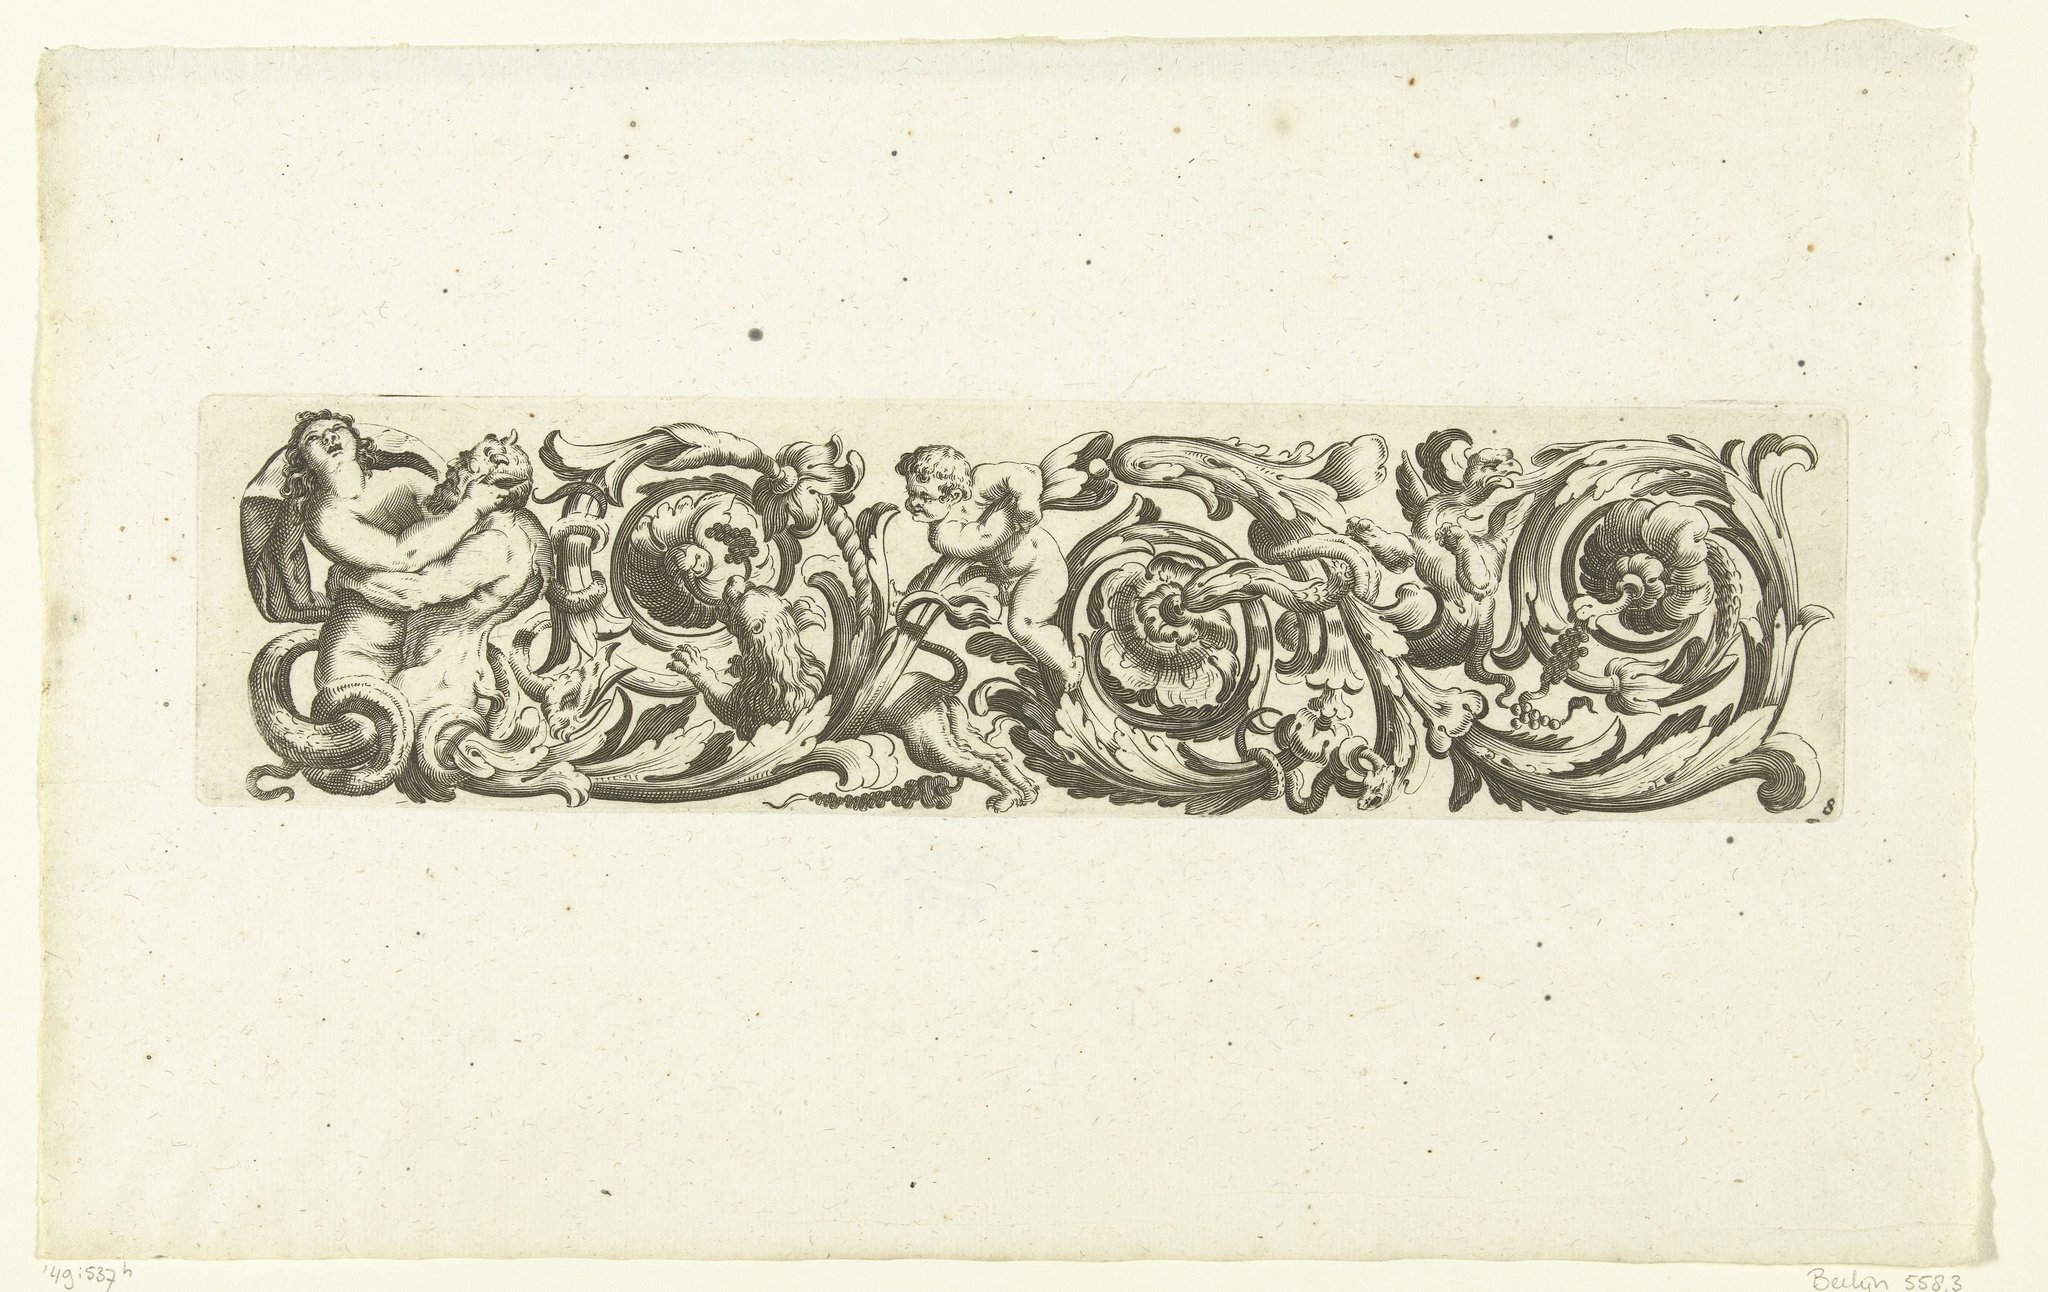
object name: ornament print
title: Bladrank met links een sater die een vrouw vastgrijpt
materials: paper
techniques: engraving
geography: netherlands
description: Blad 8 uit serie met Nederlandse tegenzijdige verkleinde kopieën van de serie Disegnii Varii Di Polifilo Zancarli.